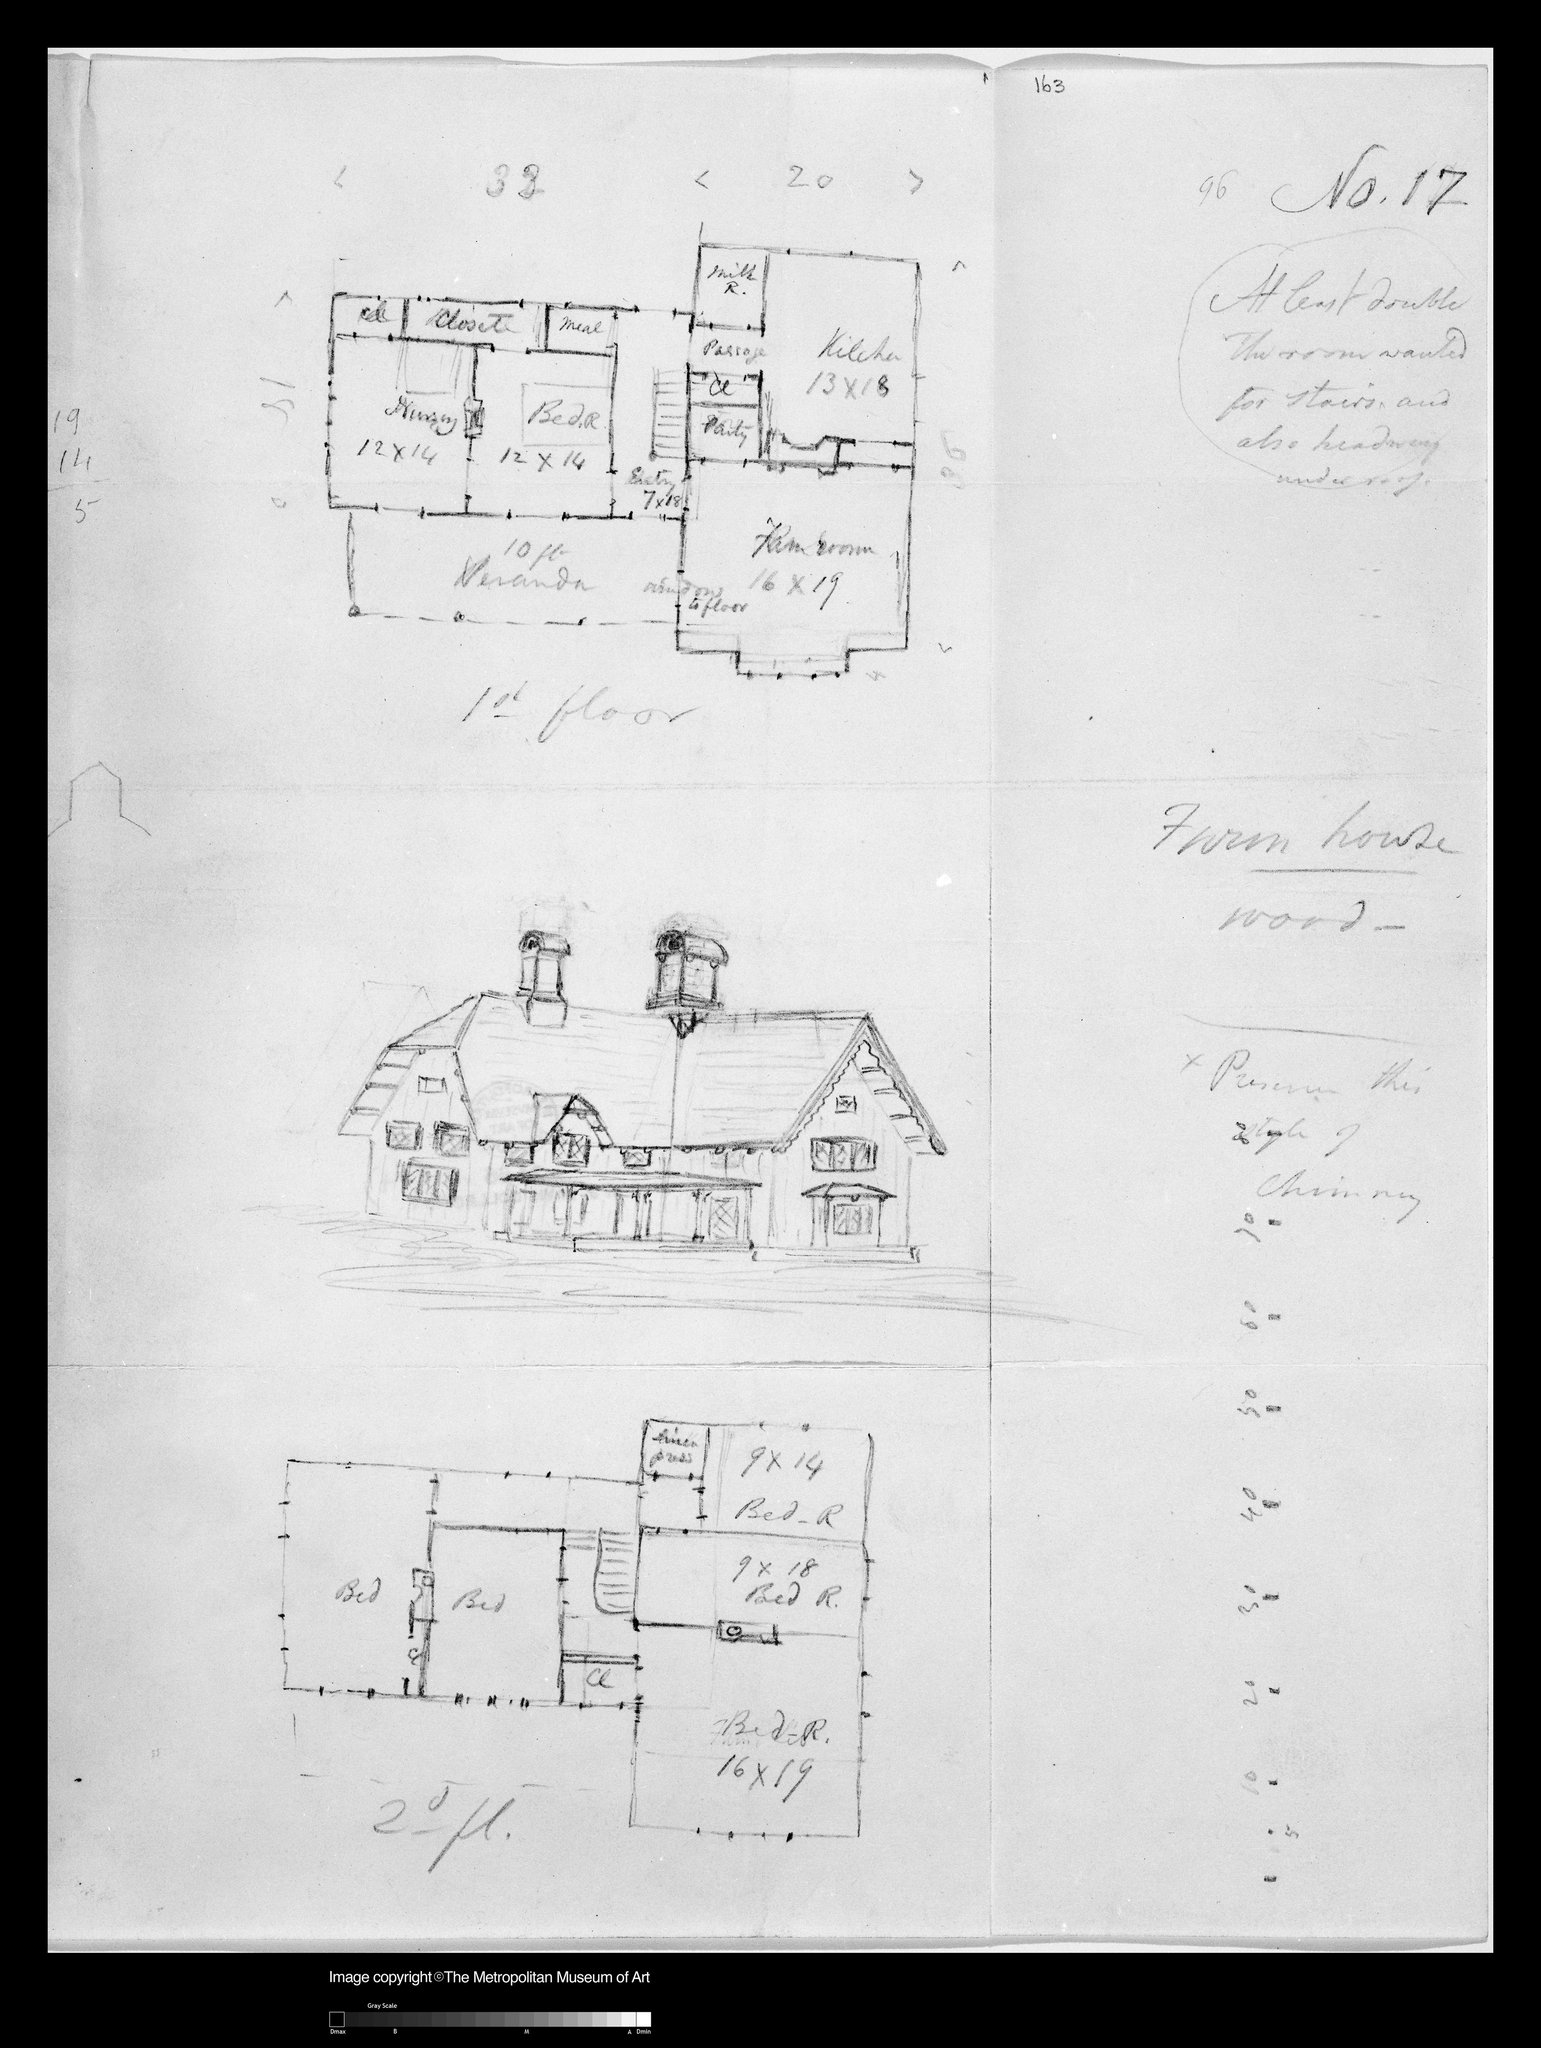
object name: drawing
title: Design for Bracketed American Farm House, Design XVII from The Architecture of Country Houses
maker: alexander jackson davis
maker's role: artist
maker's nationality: american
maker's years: 1803-1892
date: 1850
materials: graphite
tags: architecture,houses